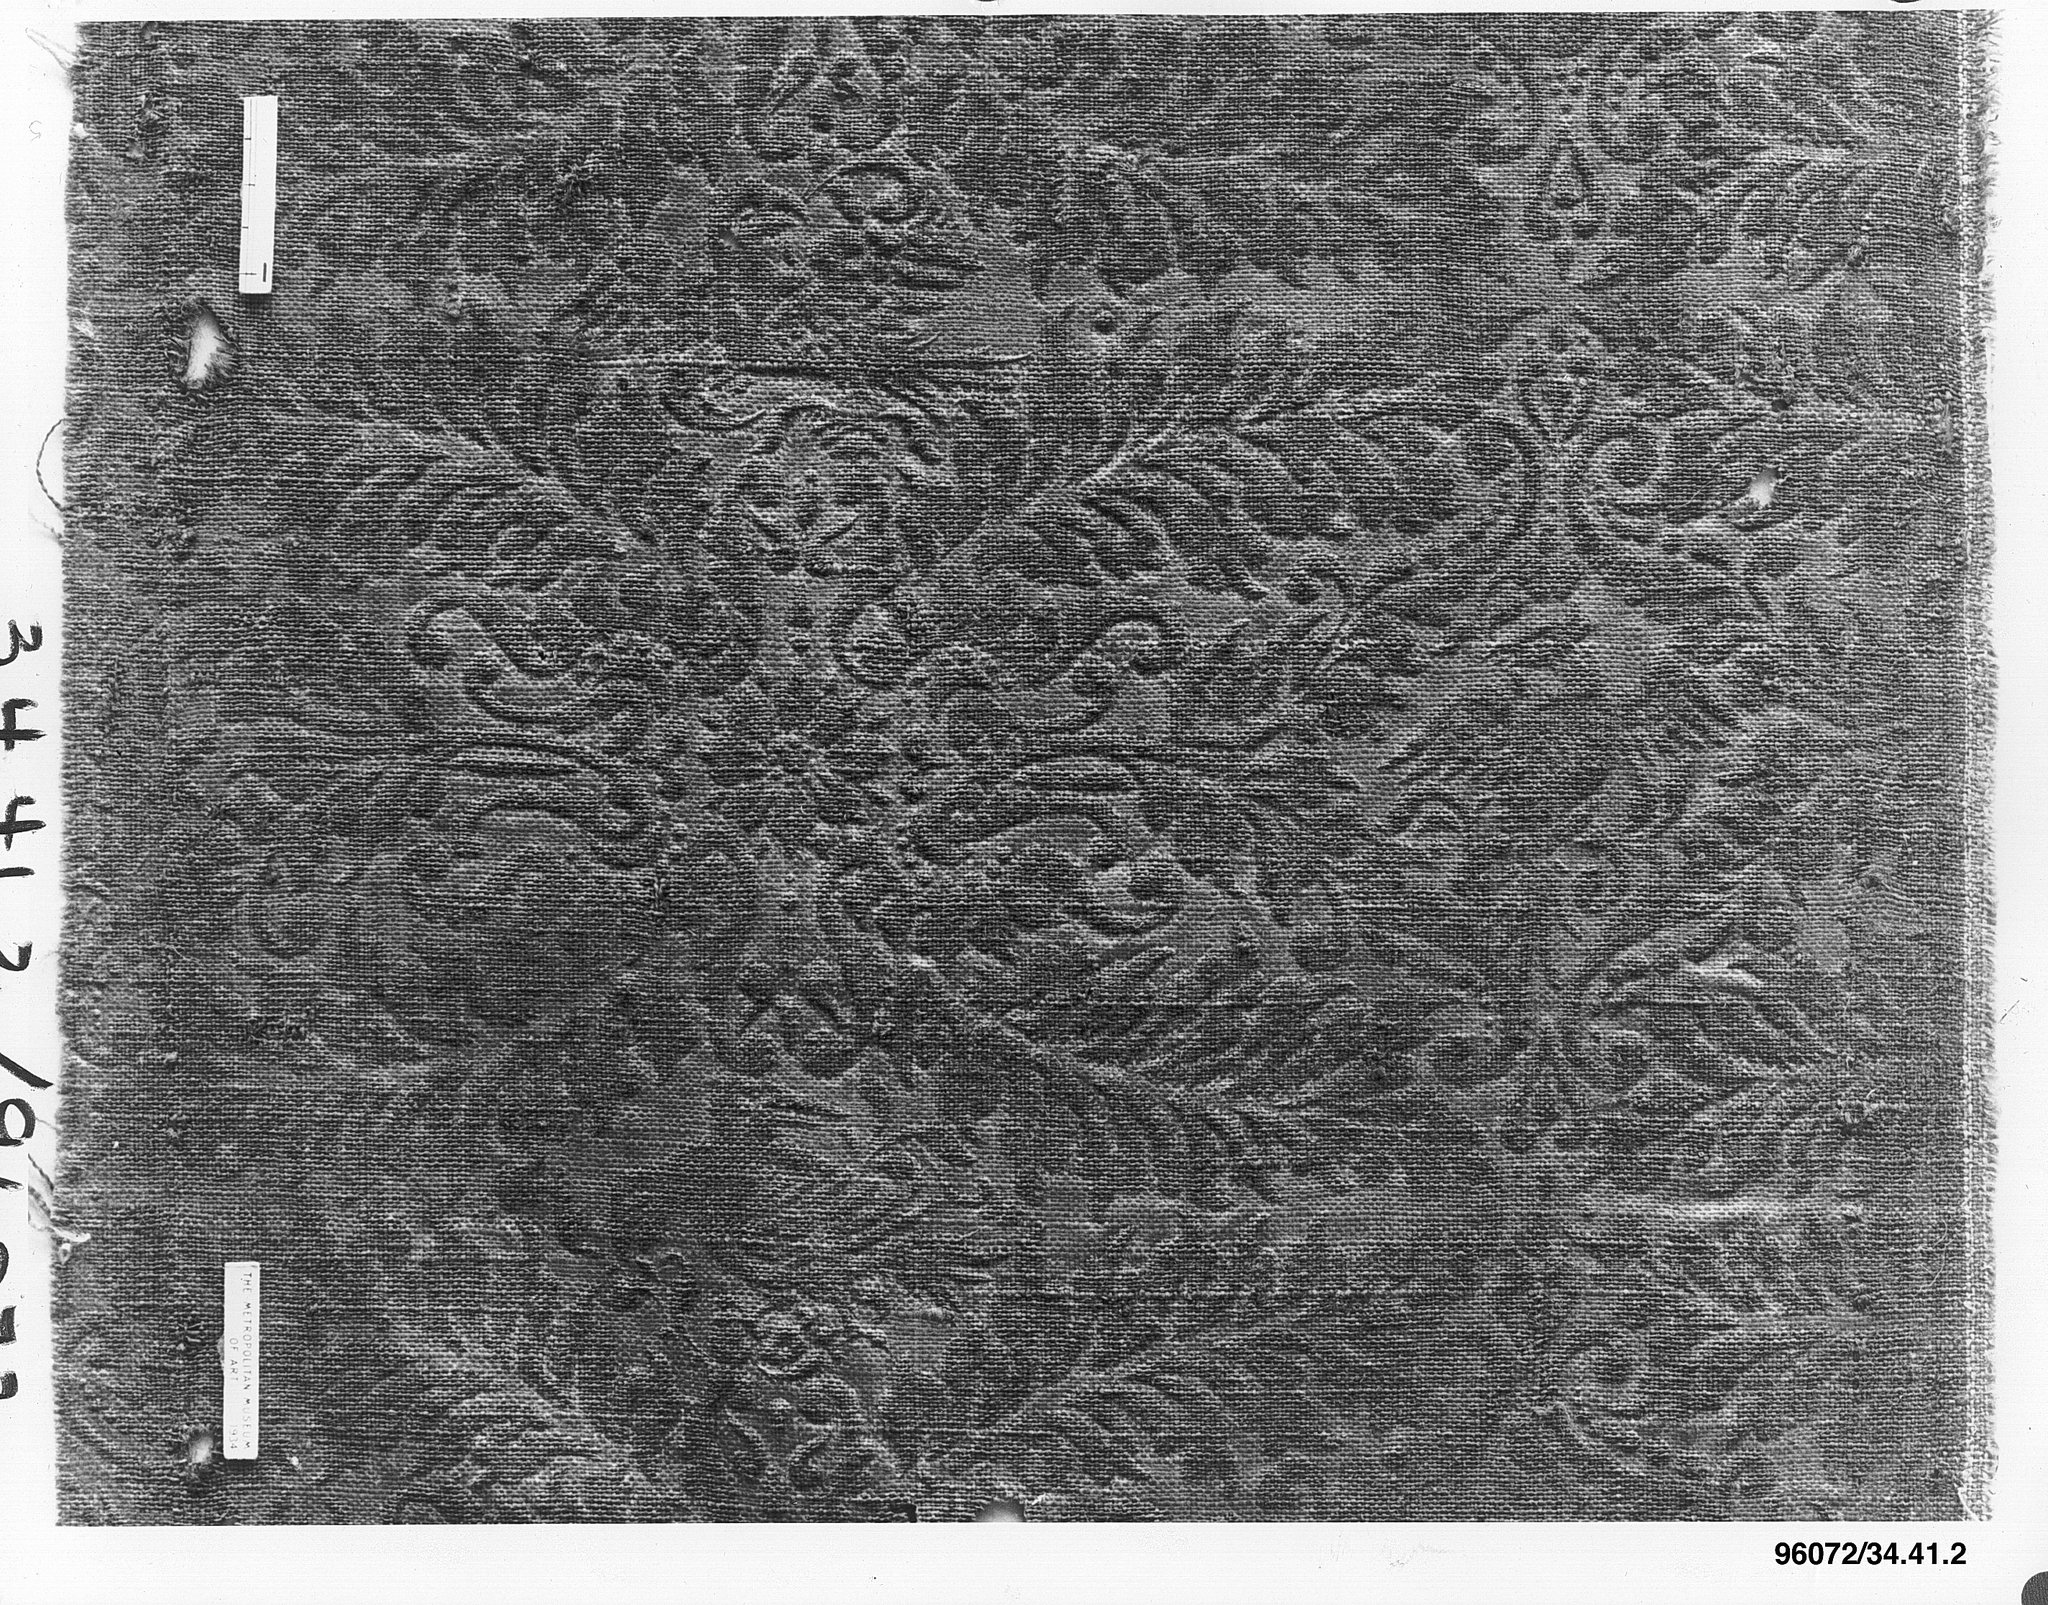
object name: piece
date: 1501-1600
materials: wool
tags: leaves